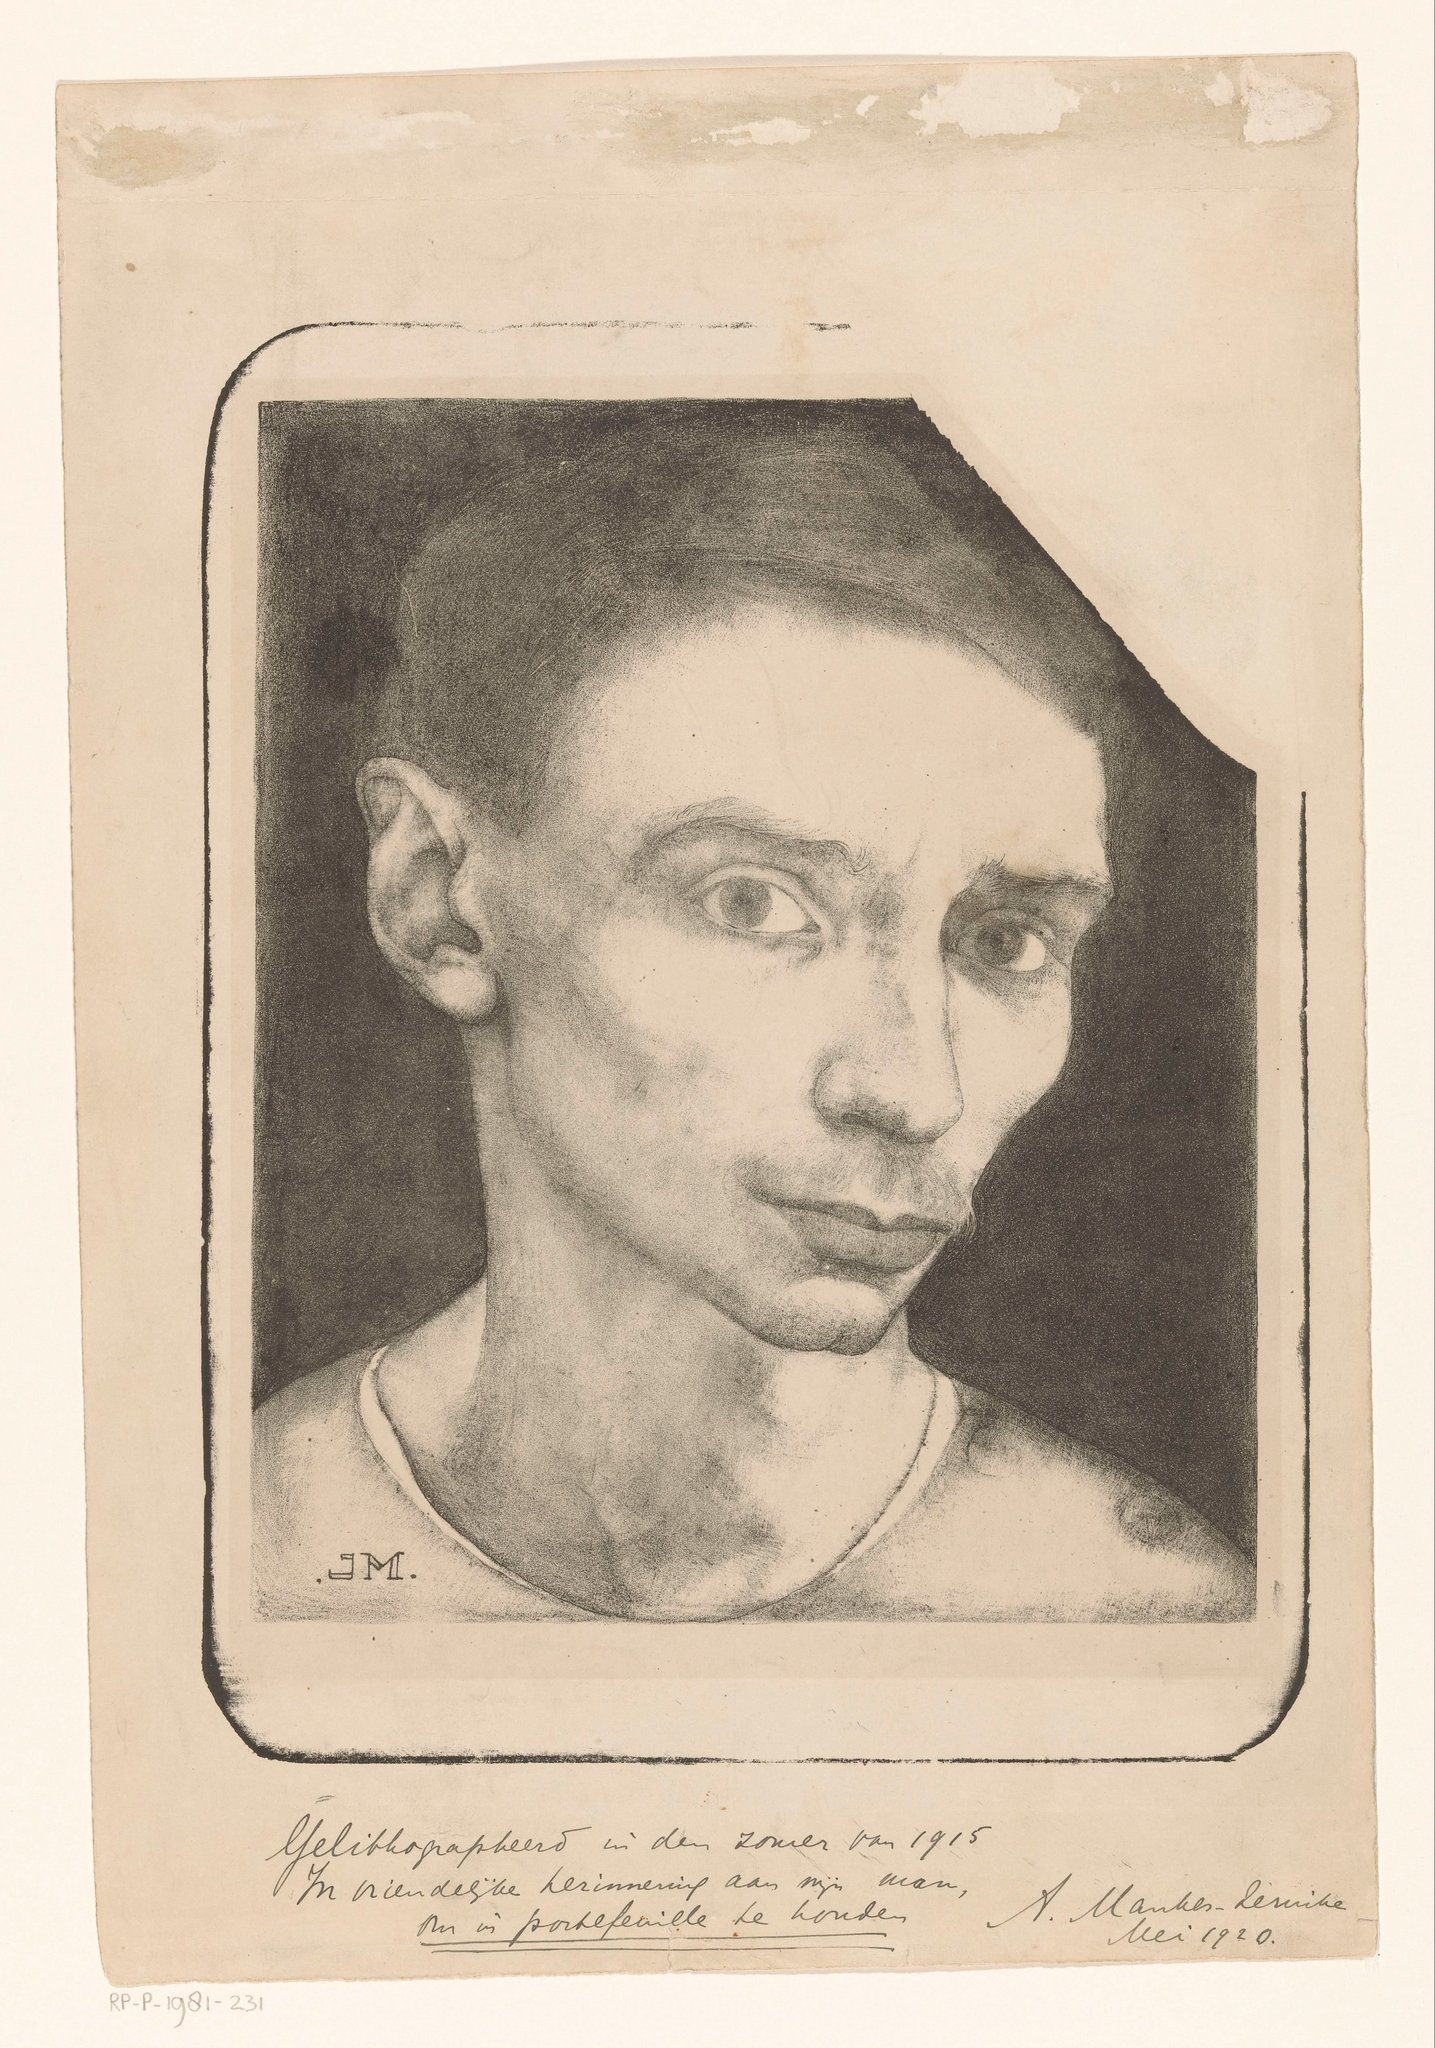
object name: print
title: Zelfportret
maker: jan mankes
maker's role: draughtsman, painter, print maker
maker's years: 1889-1920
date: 1915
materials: paper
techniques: lithograph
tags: painter, print maker, draughtsman, jan mankes, portrait, self-portrait of artist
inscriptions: collector's mark: Lugt 2228, dedication: ‘Gelithographeerd in den zomer van 1915. In vriendelijke herinnering aan mijn man, nu in portefeuille te houden. A. Mankes-Zernike Mei 1920.’